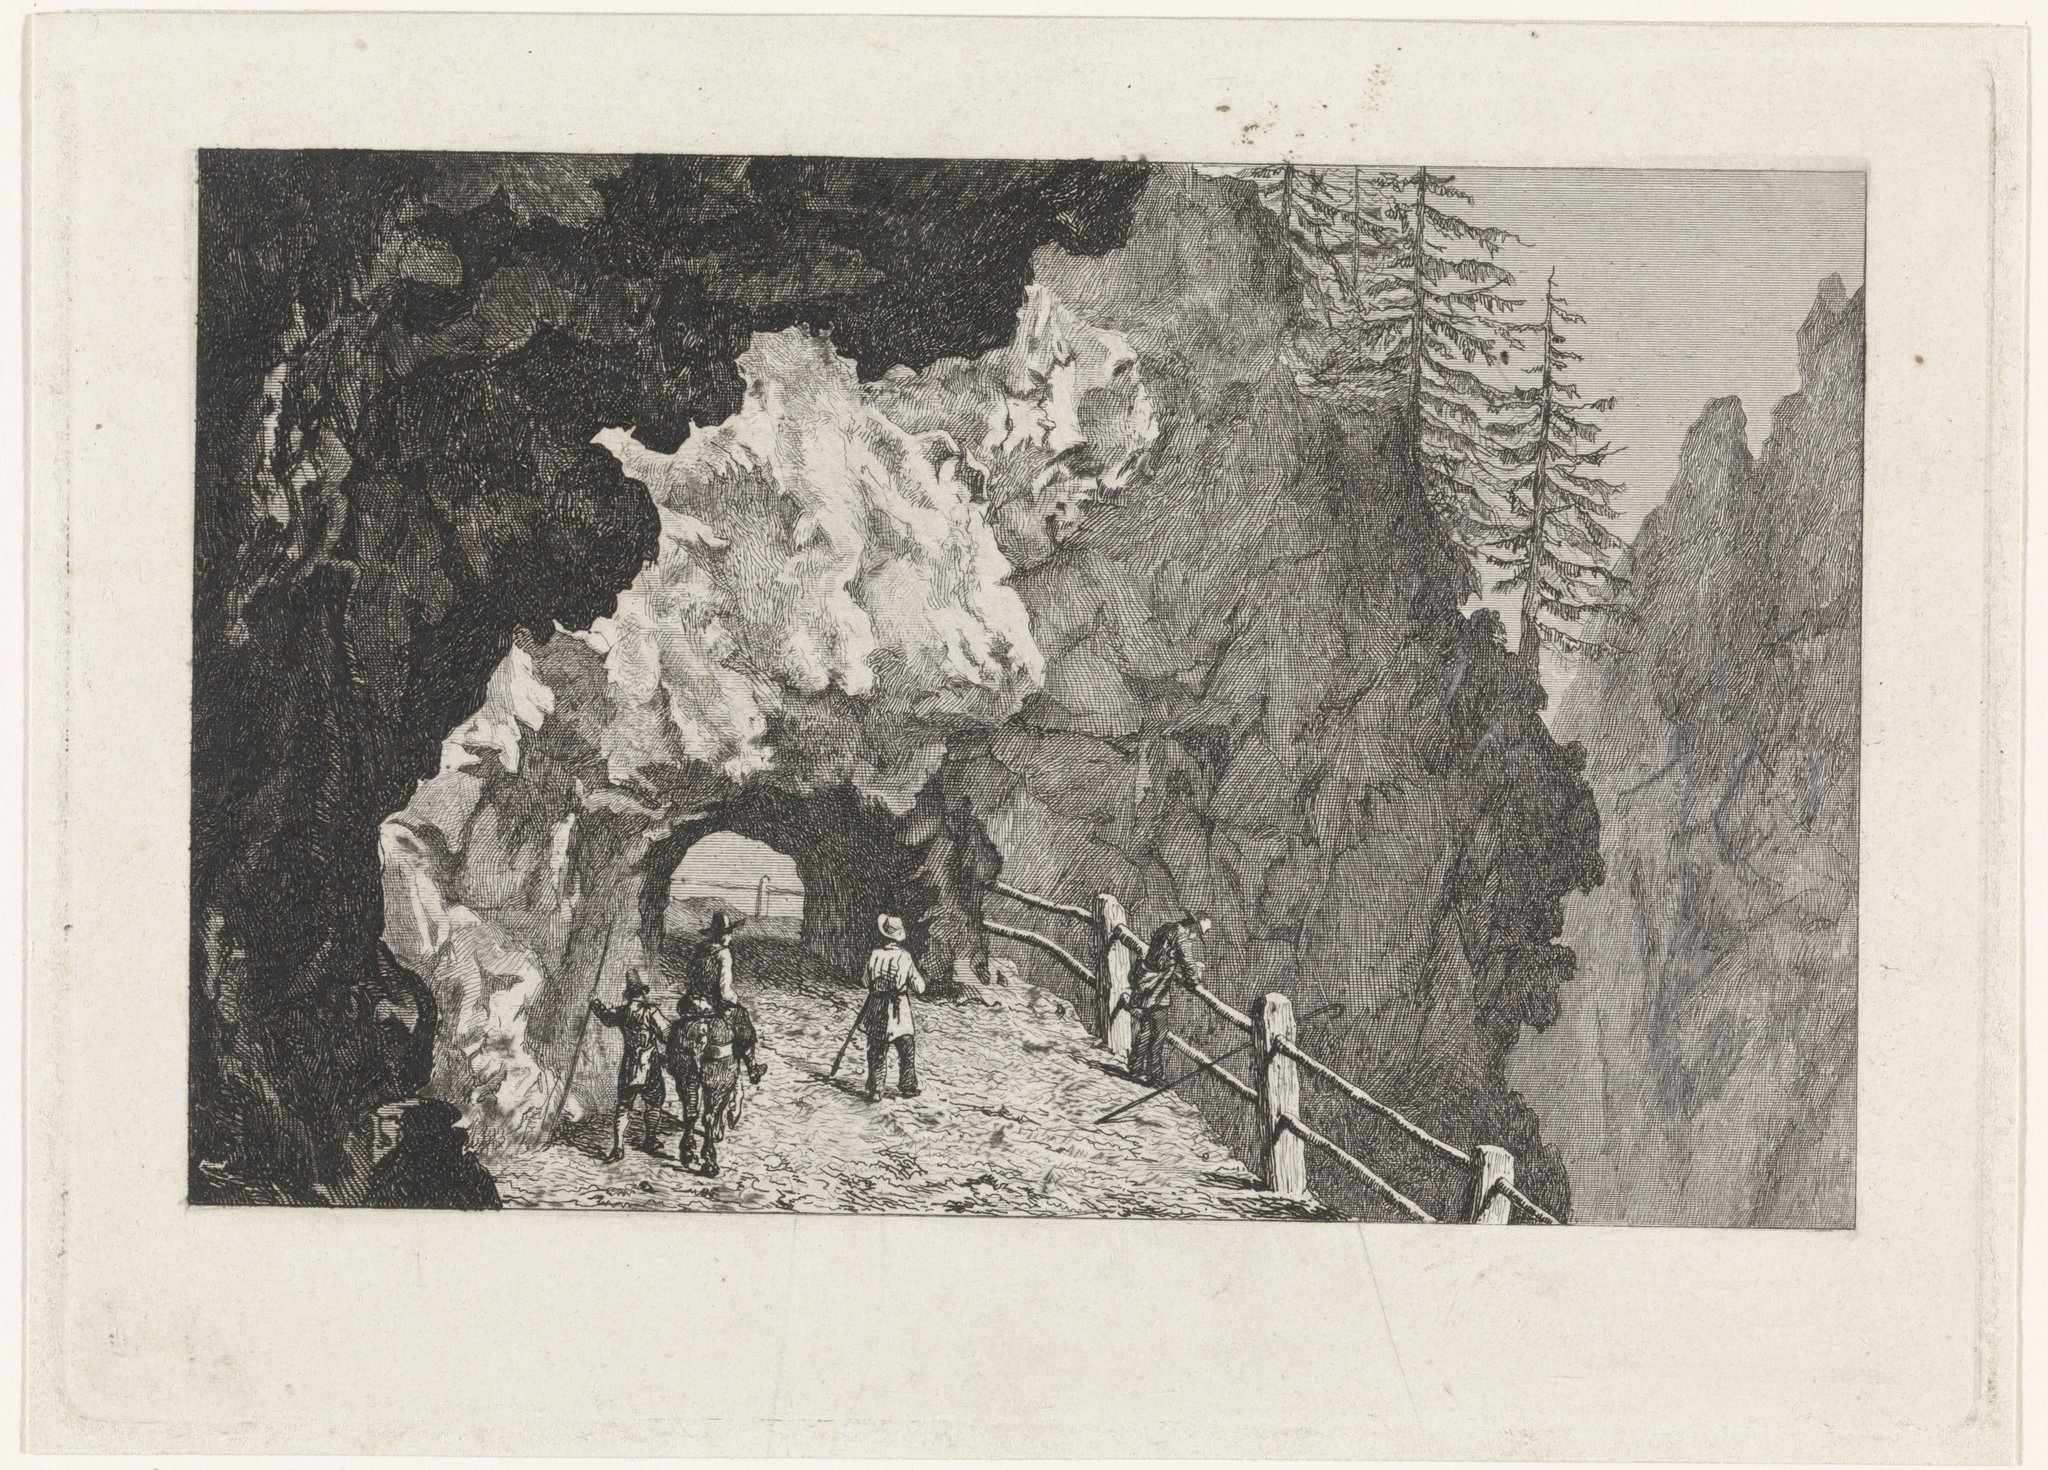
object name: print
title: Doorgang in de rotsen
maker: david van der kellen (1827-1895)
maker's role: draughtsman, print maker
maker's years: 1827-1895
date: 1837-1885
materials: paper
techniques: drypoint, etching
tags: horse, 'en route', traveller under way, rocks, mountains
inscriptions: collector's mark: Lugt 2228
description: Gezicht op een doorgang in de rotsen, met op het bergpad drie voetgangers en een ruiter. Links van de weg een rotswand en rechts een afgrond waar een van de mannen naar beneden staat te kijken.